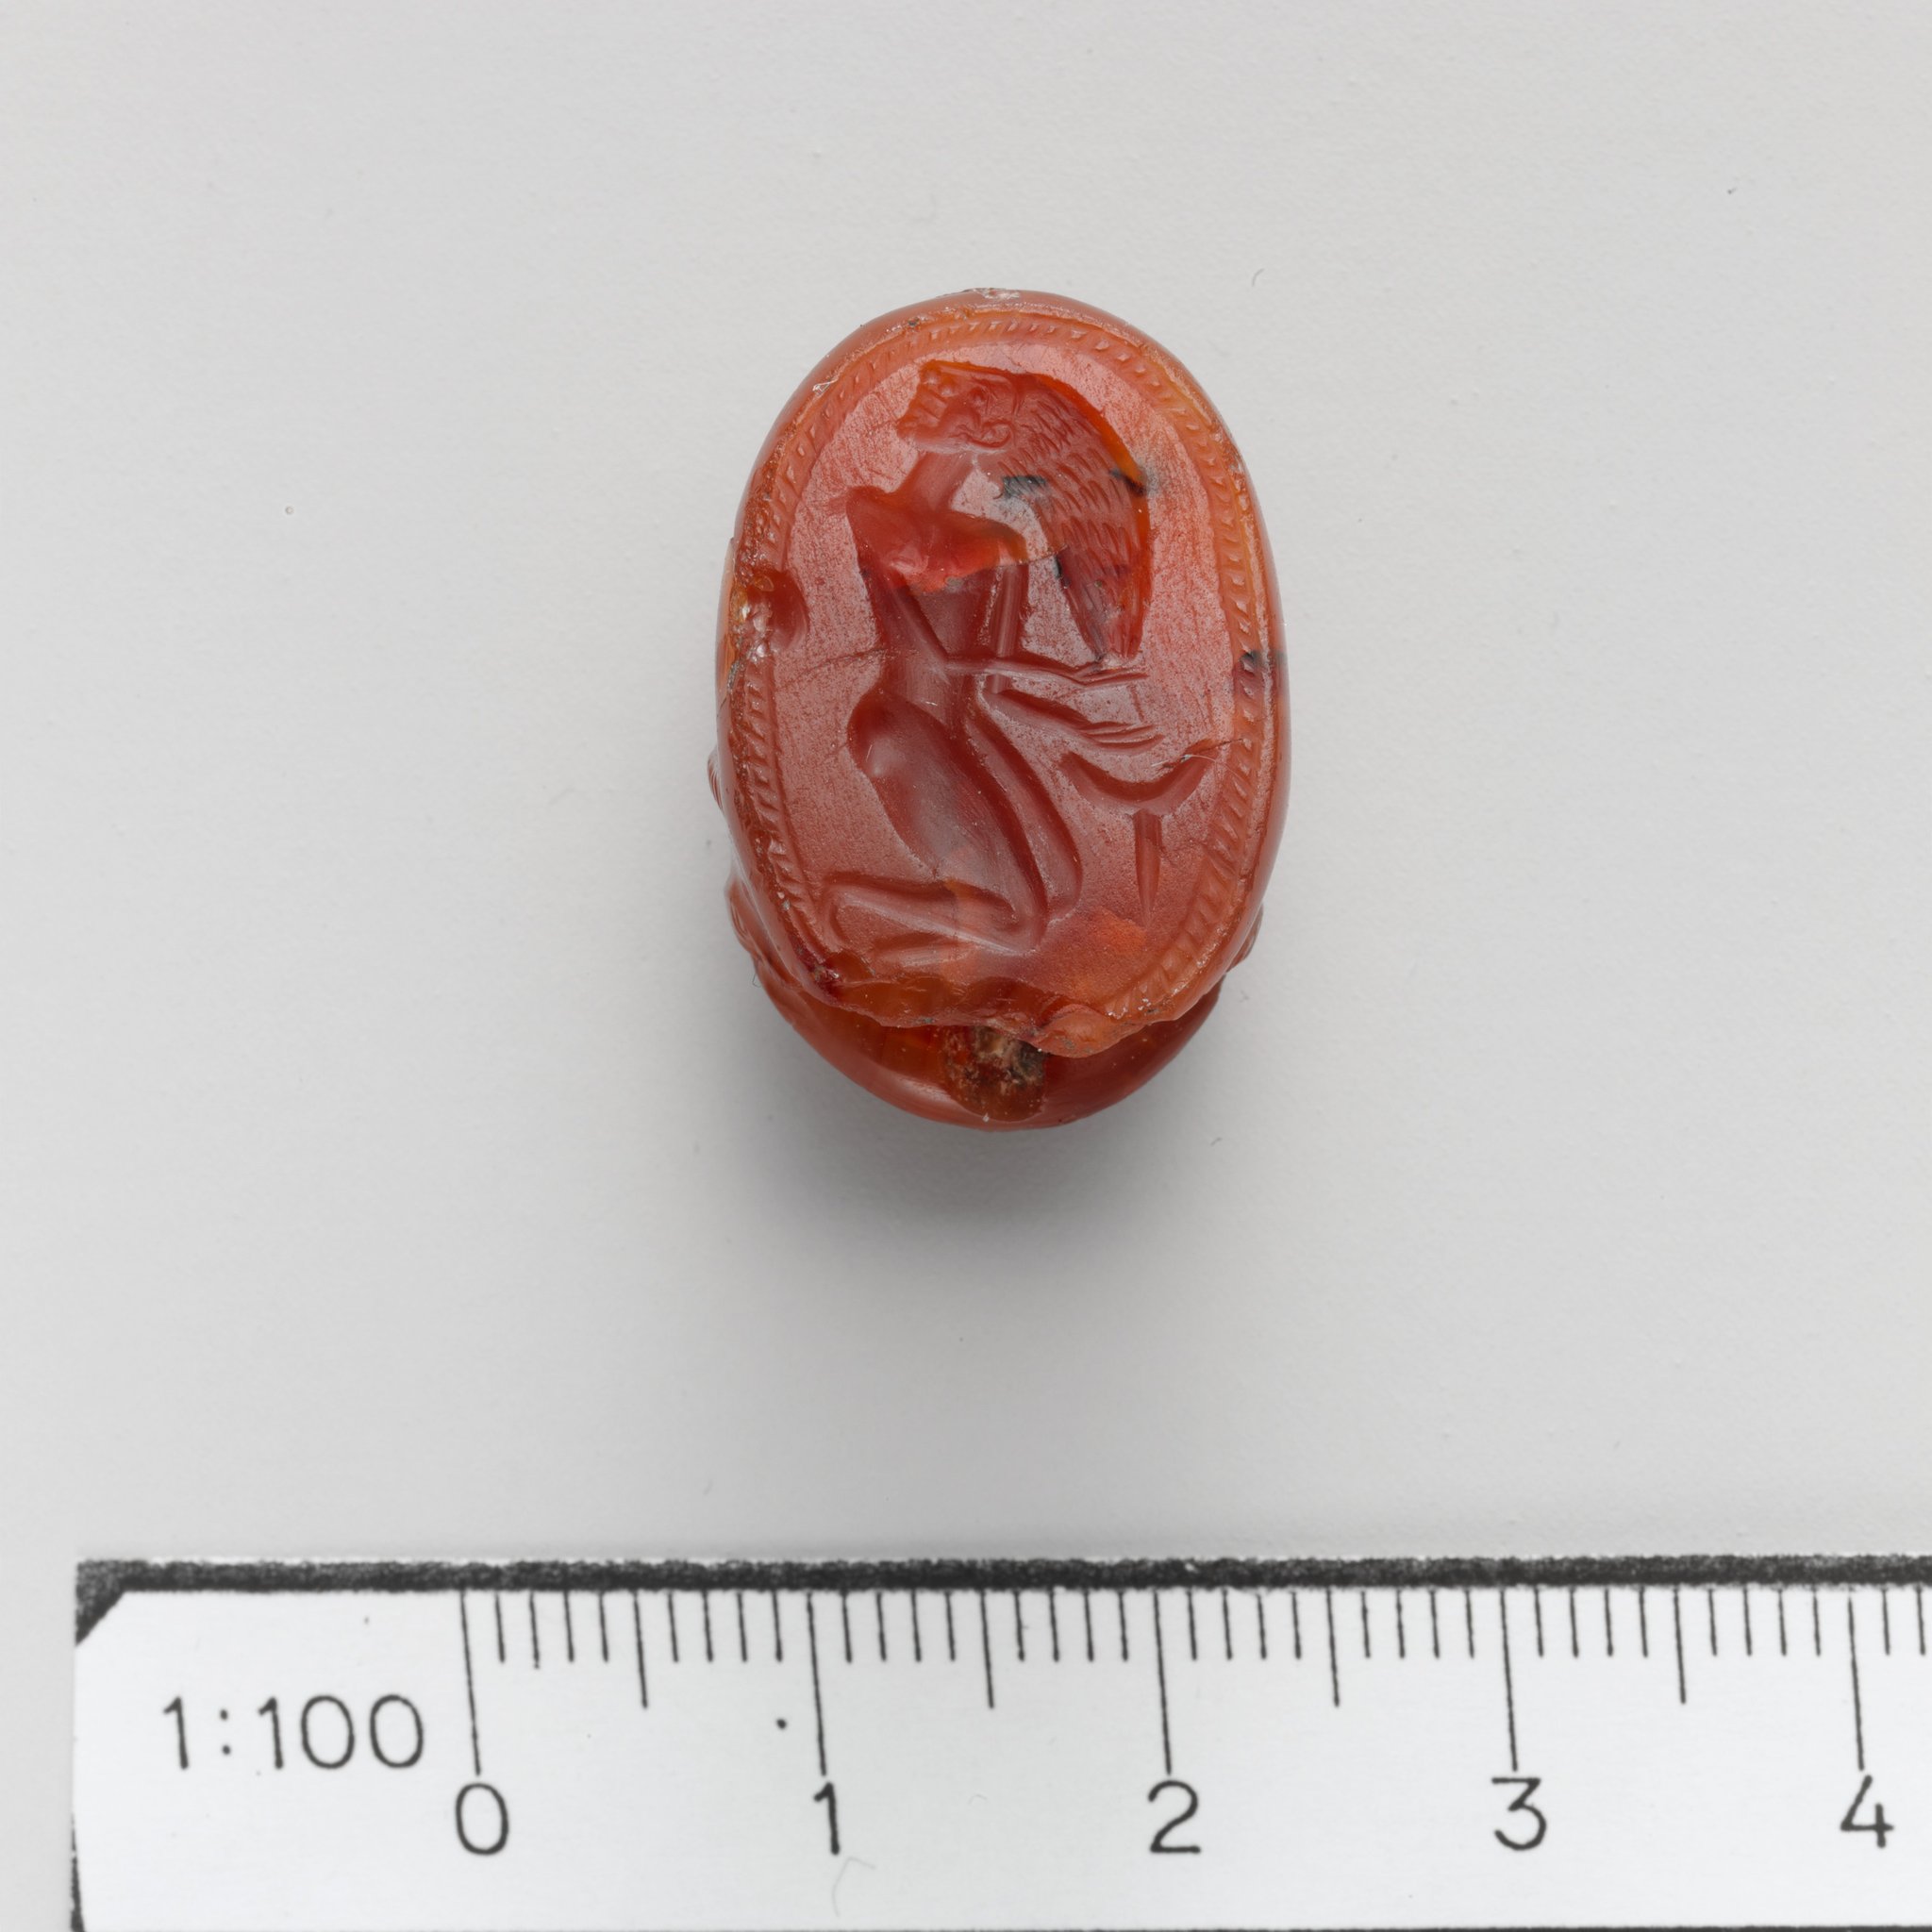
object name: scarab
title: Carnelian scarab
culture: greek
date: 550-526 BCE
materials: gemstone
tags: hair,girls